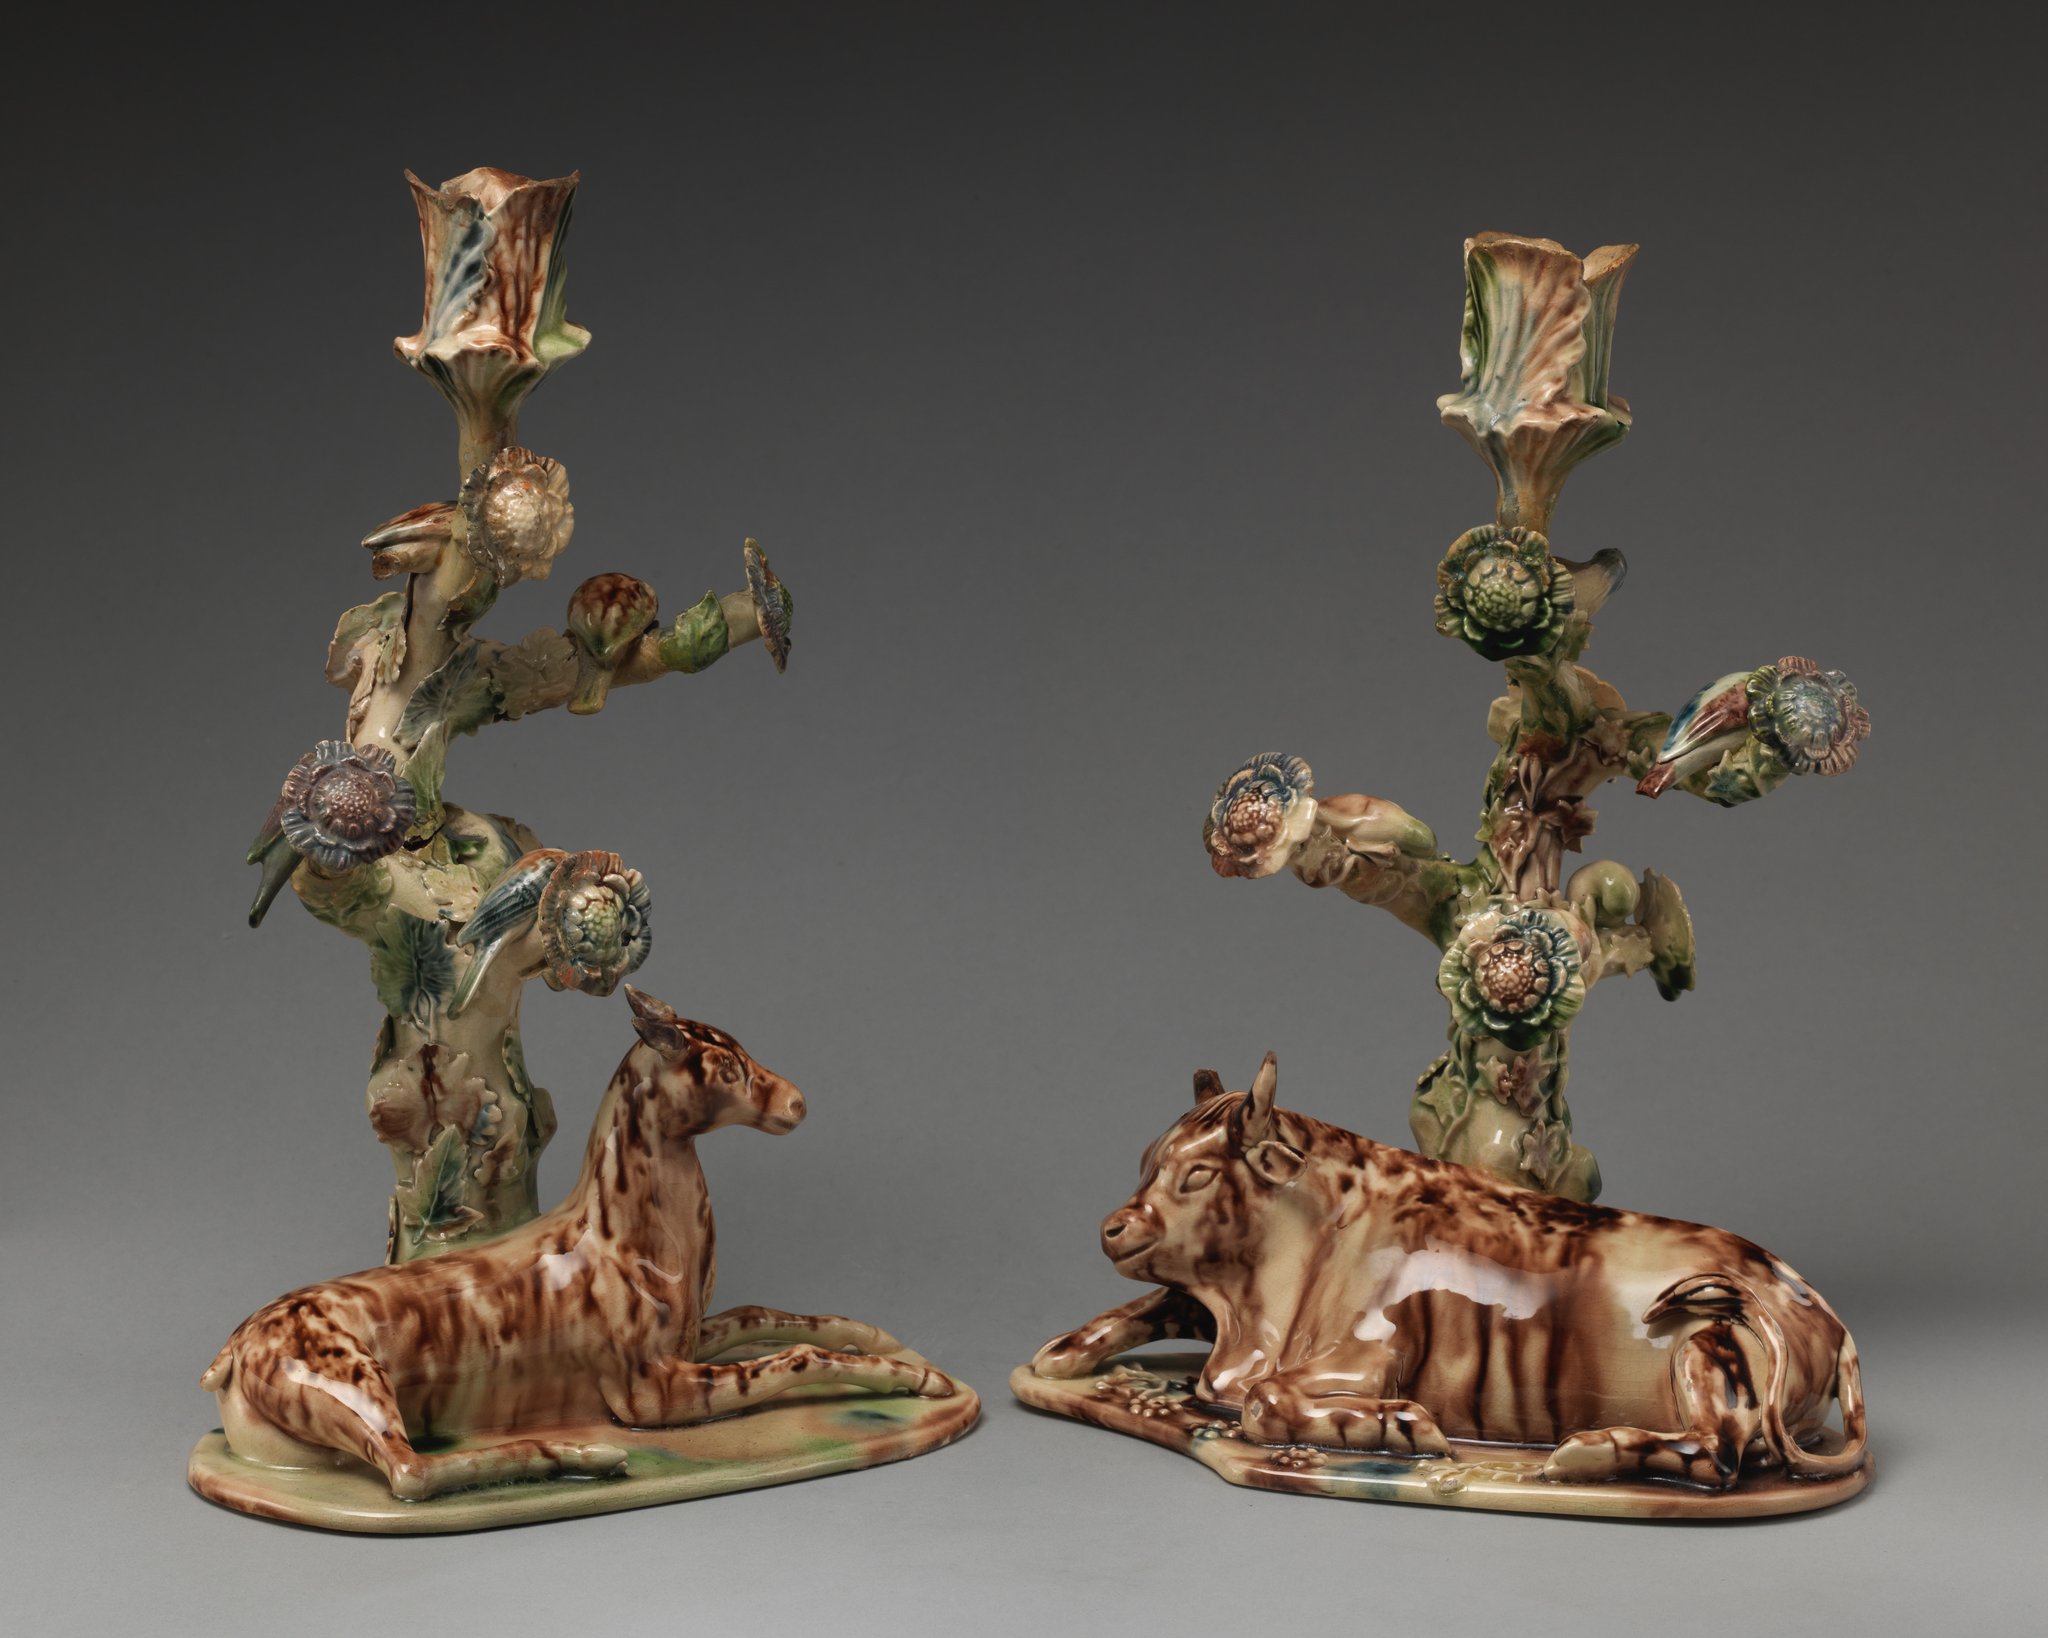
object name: candlestick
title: Pair of candlesticks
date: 1880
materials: earthenware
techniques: glazing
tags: bulls,deer,trees